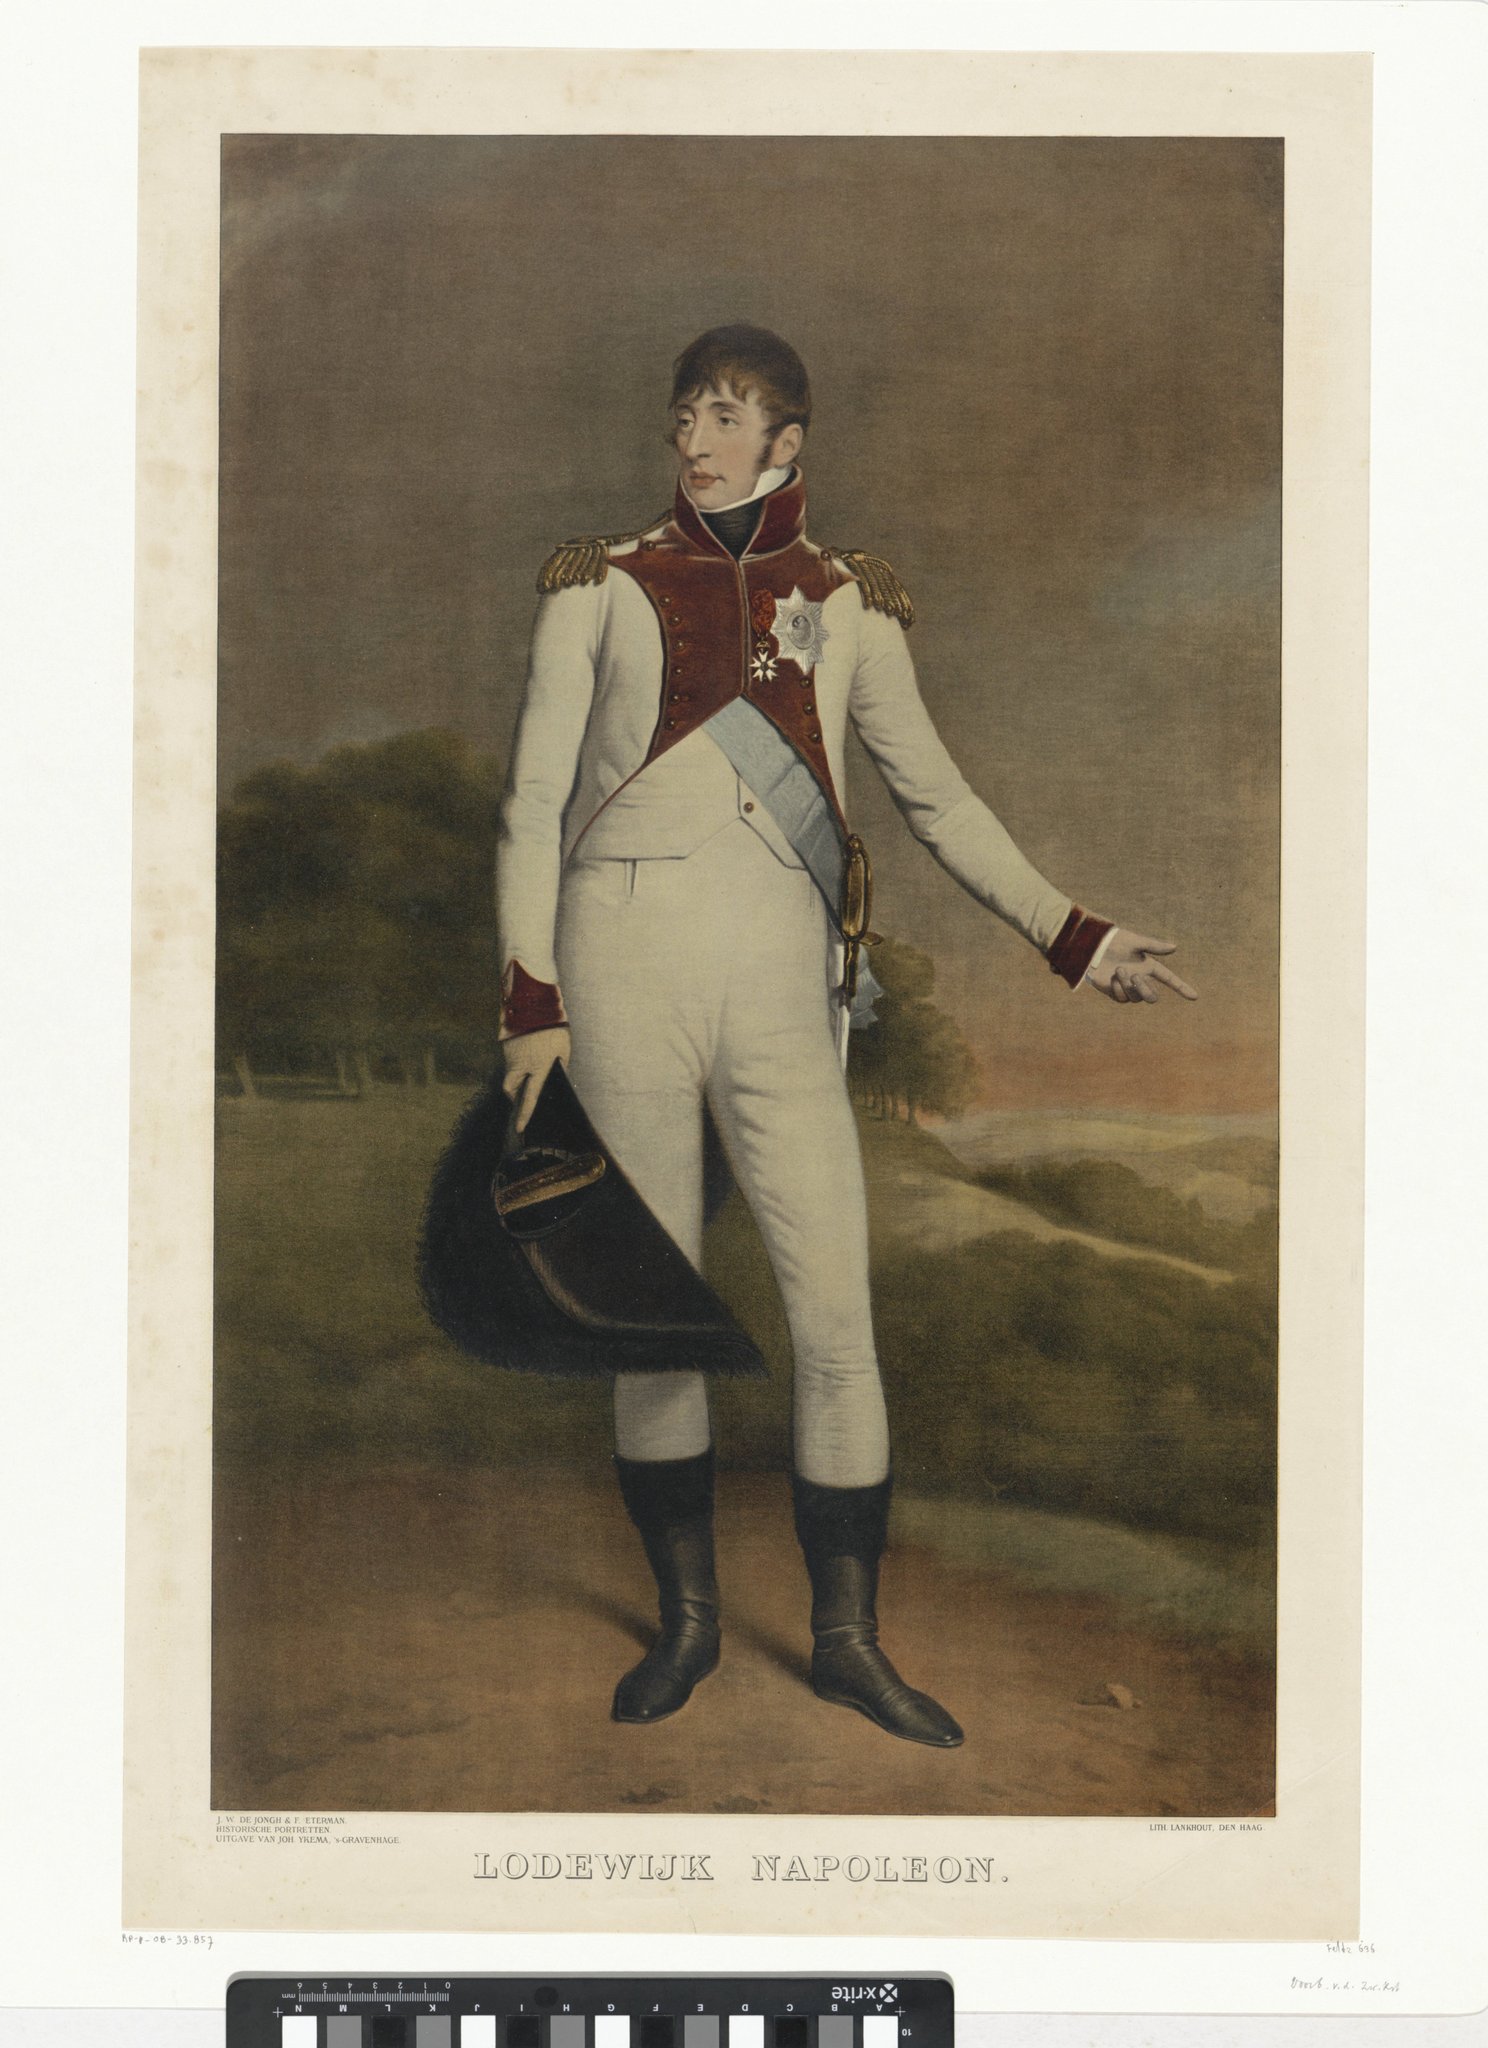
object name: photomechanical print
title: Portret van Lodewijk Napoleon, Koning van Holland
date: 1856-1867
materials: paper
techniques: autotype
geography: the hague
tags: louis napoleon (king of holland), holland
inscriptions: collector's mark: Lugt 2228, collector's mark: Lugt 2760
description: Lodewijk Napoleon, koning van Holland van 1806 tot 1810. Gebarend met de linkerhand, zijn steek in de rechterhand. Hij is gekleed als kolonel van het regiment kurassiers van de koninklijke garde, getooid met het grootkruis van de koninklijke orde van de Unie van Holland en het officierskruis van het Legioen van Eer.